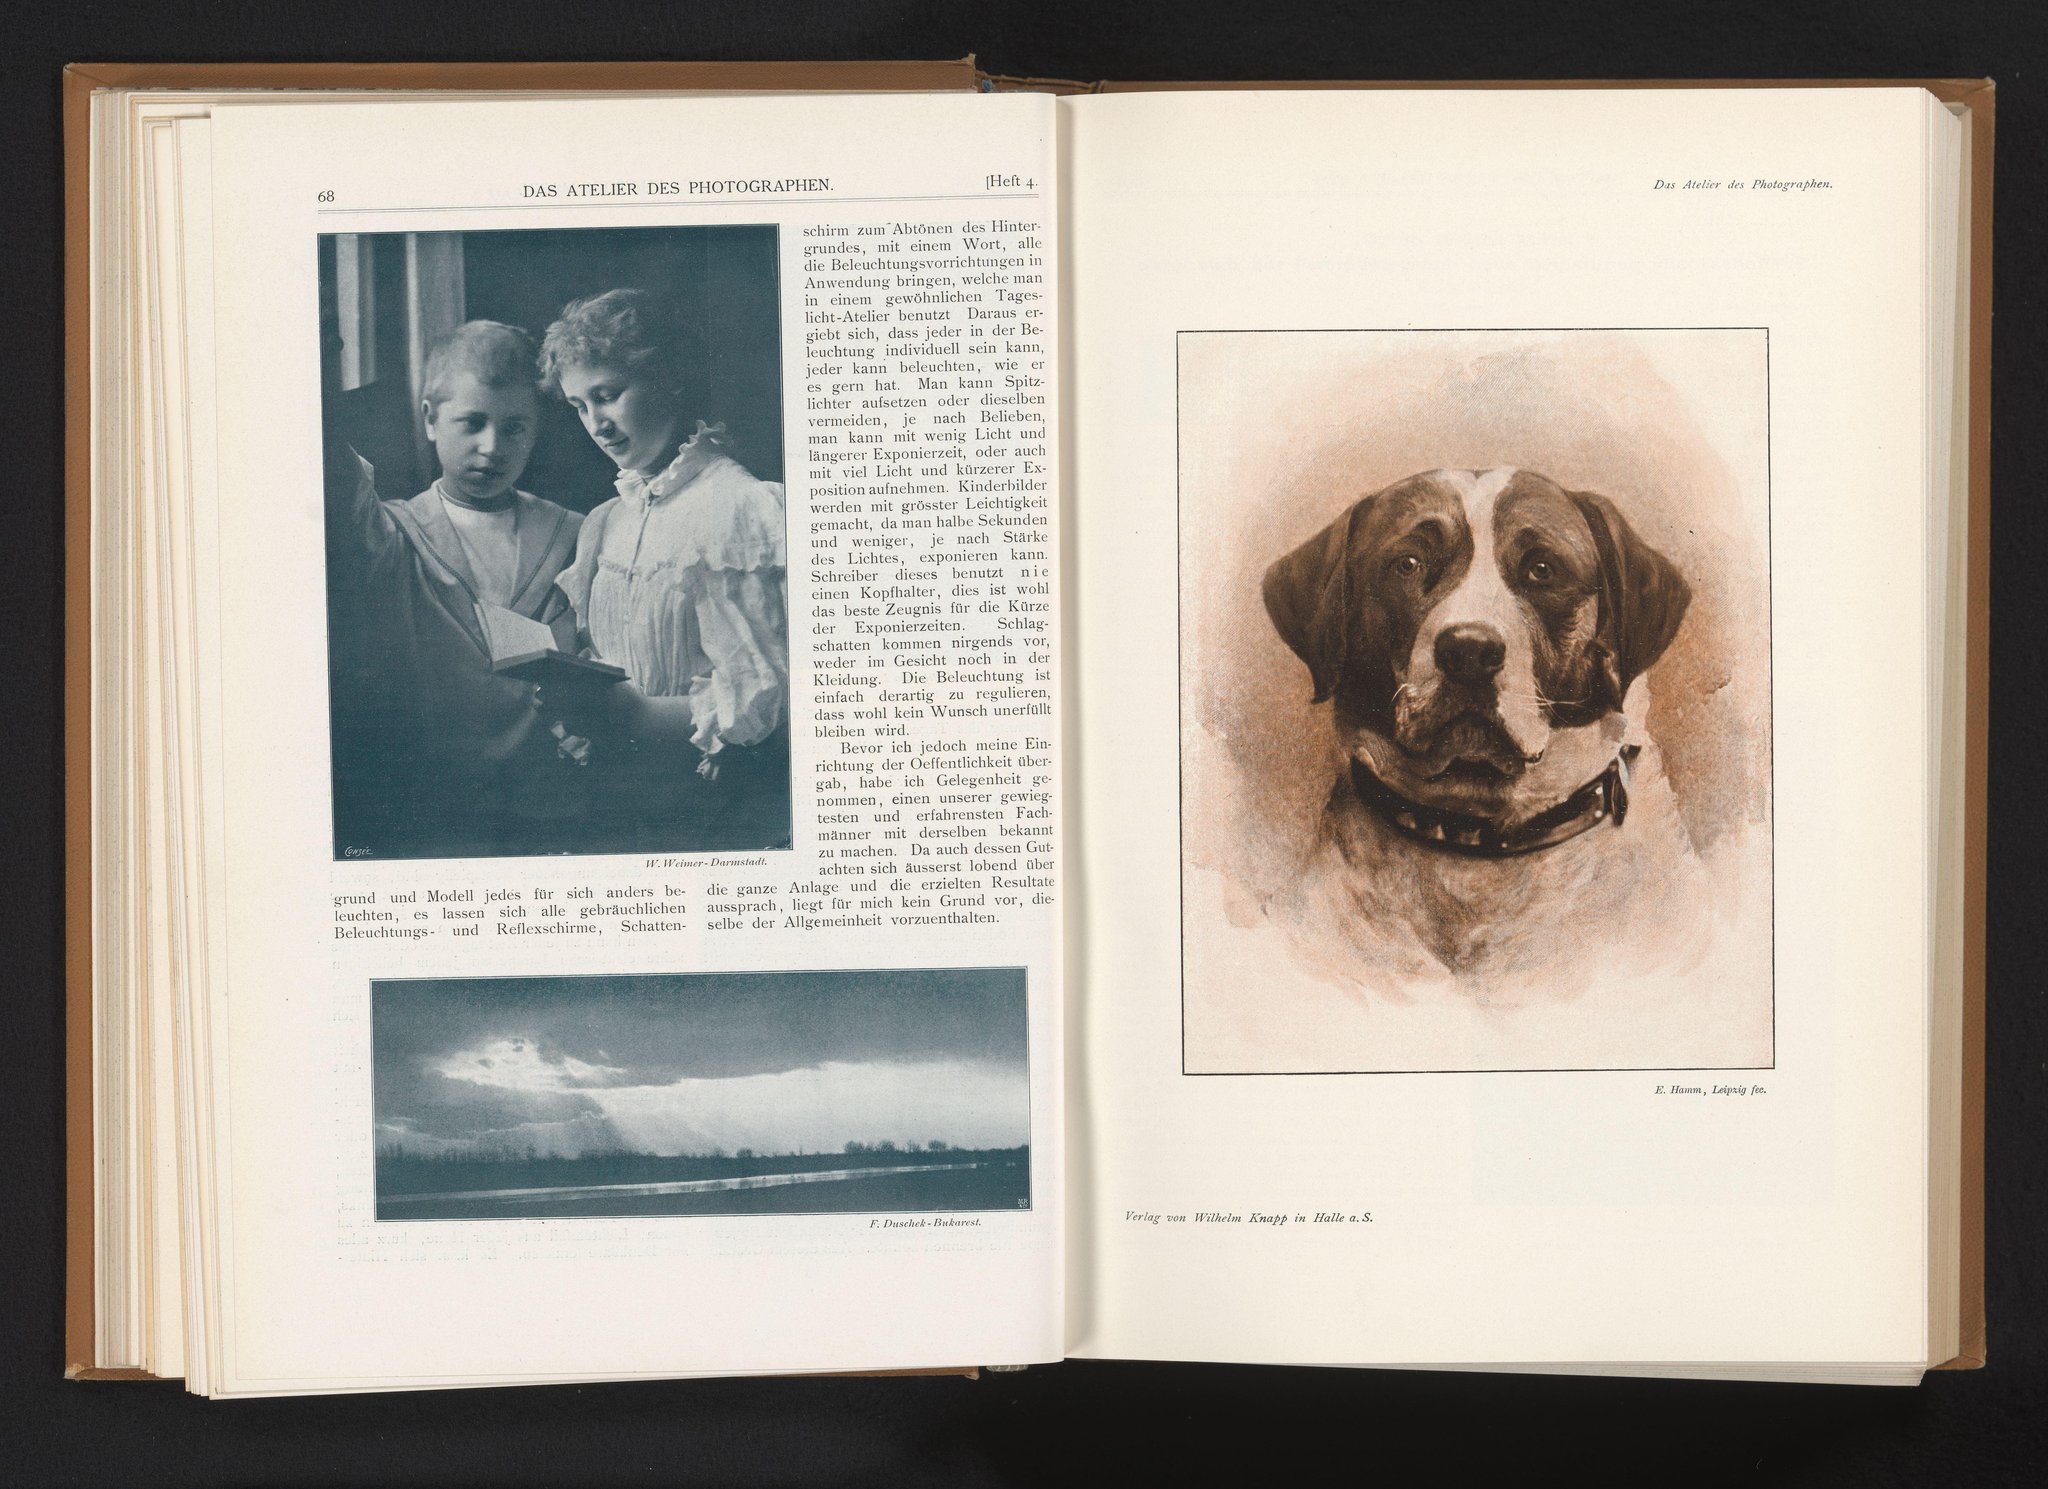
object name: photomechanical print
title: Hond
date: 1895-1900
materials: paper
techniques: two-color autotype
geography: leipzig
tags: dog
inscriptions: inscription: ‘Das Atelier des Photographen.’